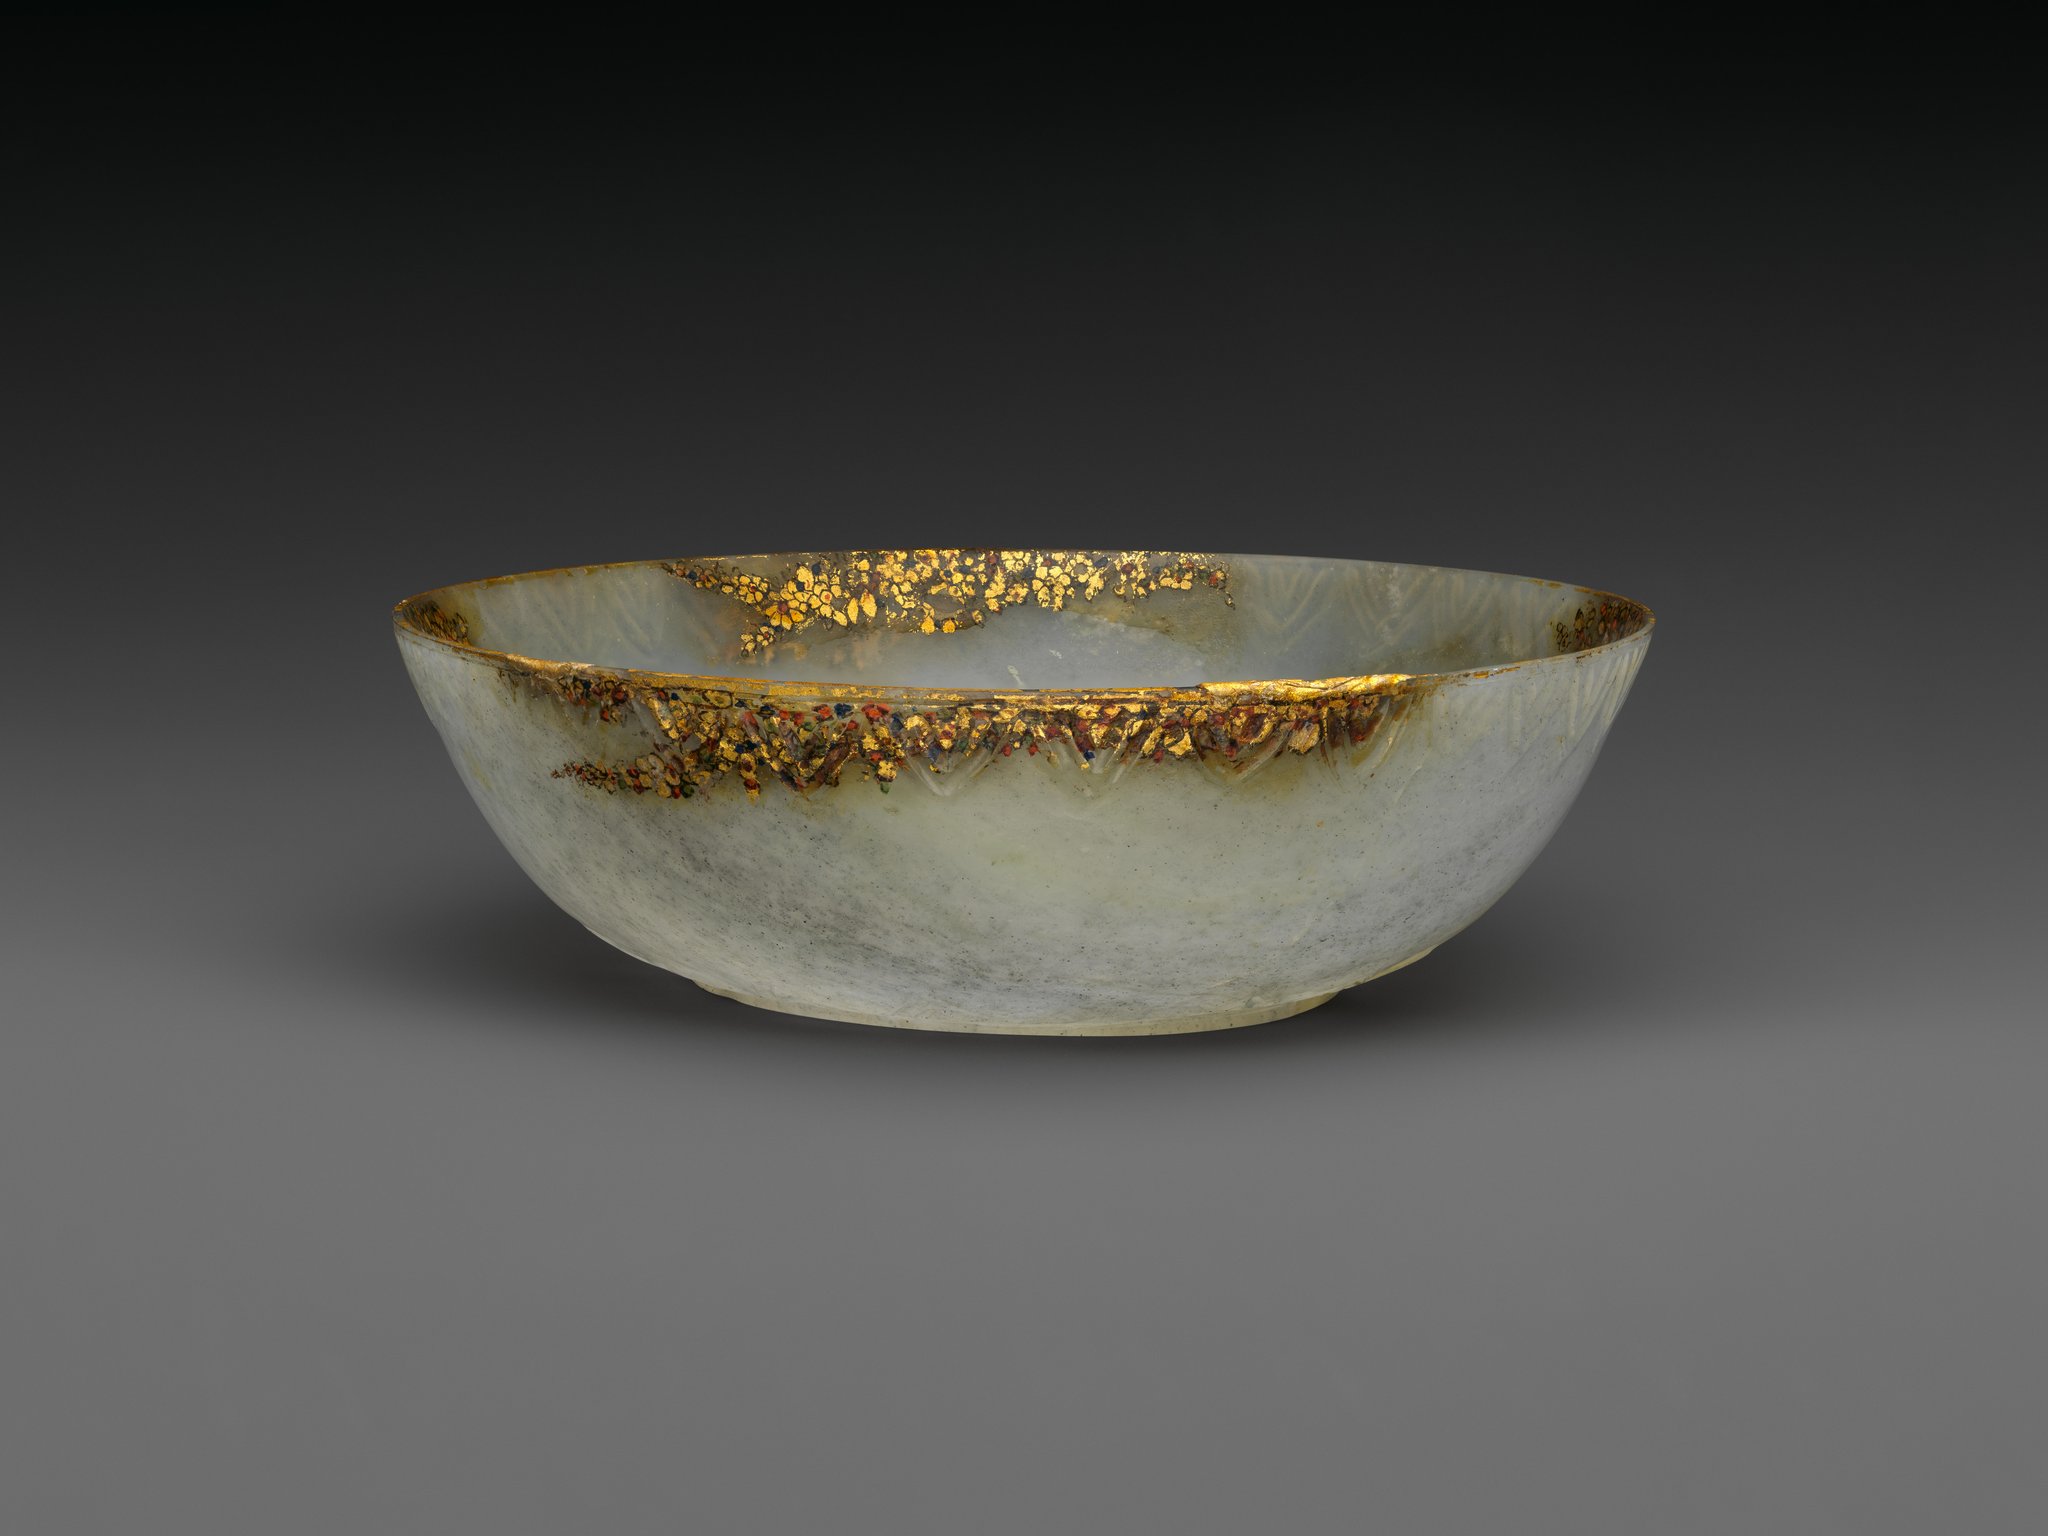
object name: bowl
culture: indian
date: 1701-1900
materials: jade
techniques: painting